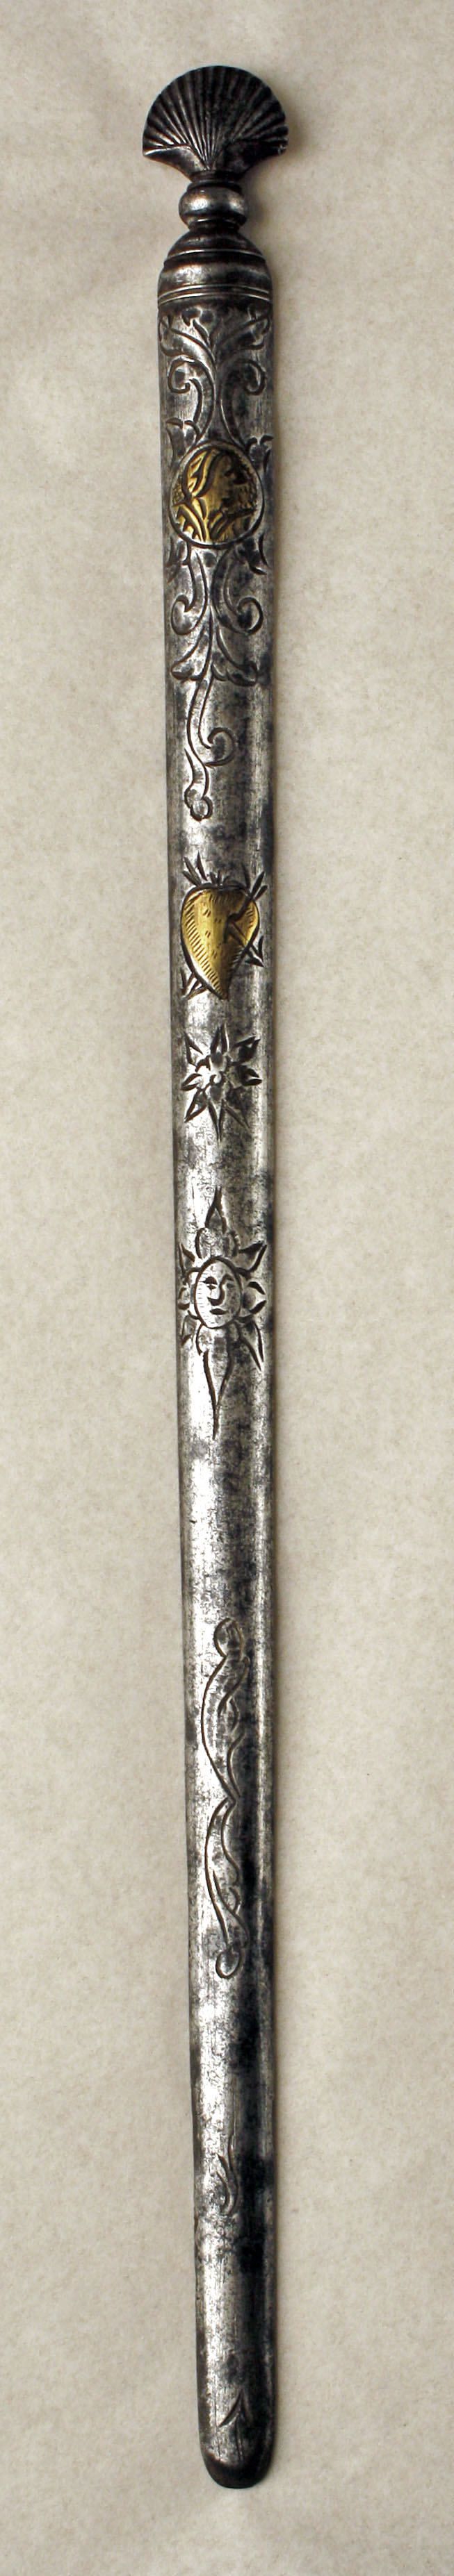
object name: busk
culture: french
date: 1601-1700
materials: metal